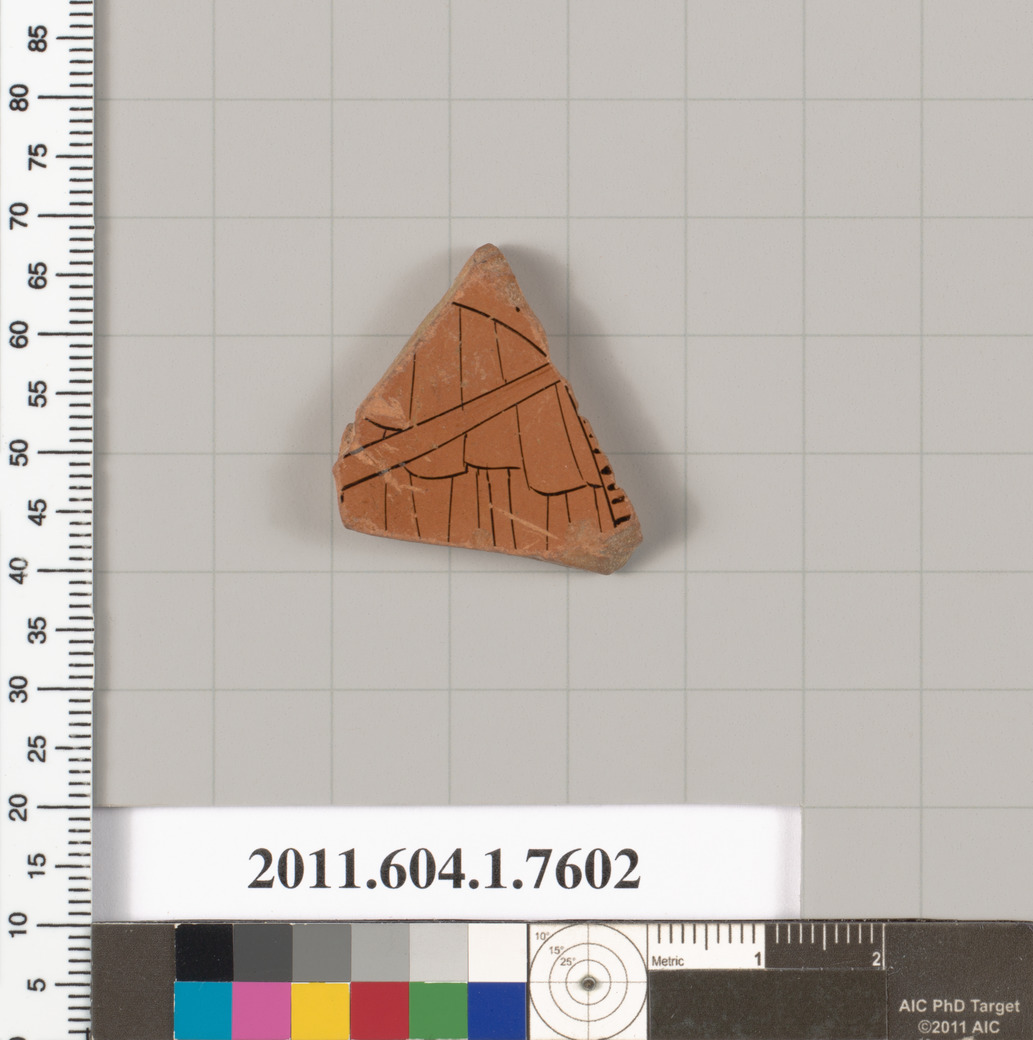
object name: kylix fragment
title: Terracotta fragment of a kylix (drinking cup)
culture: greek, attic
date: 460-450 BCE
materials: terracotta